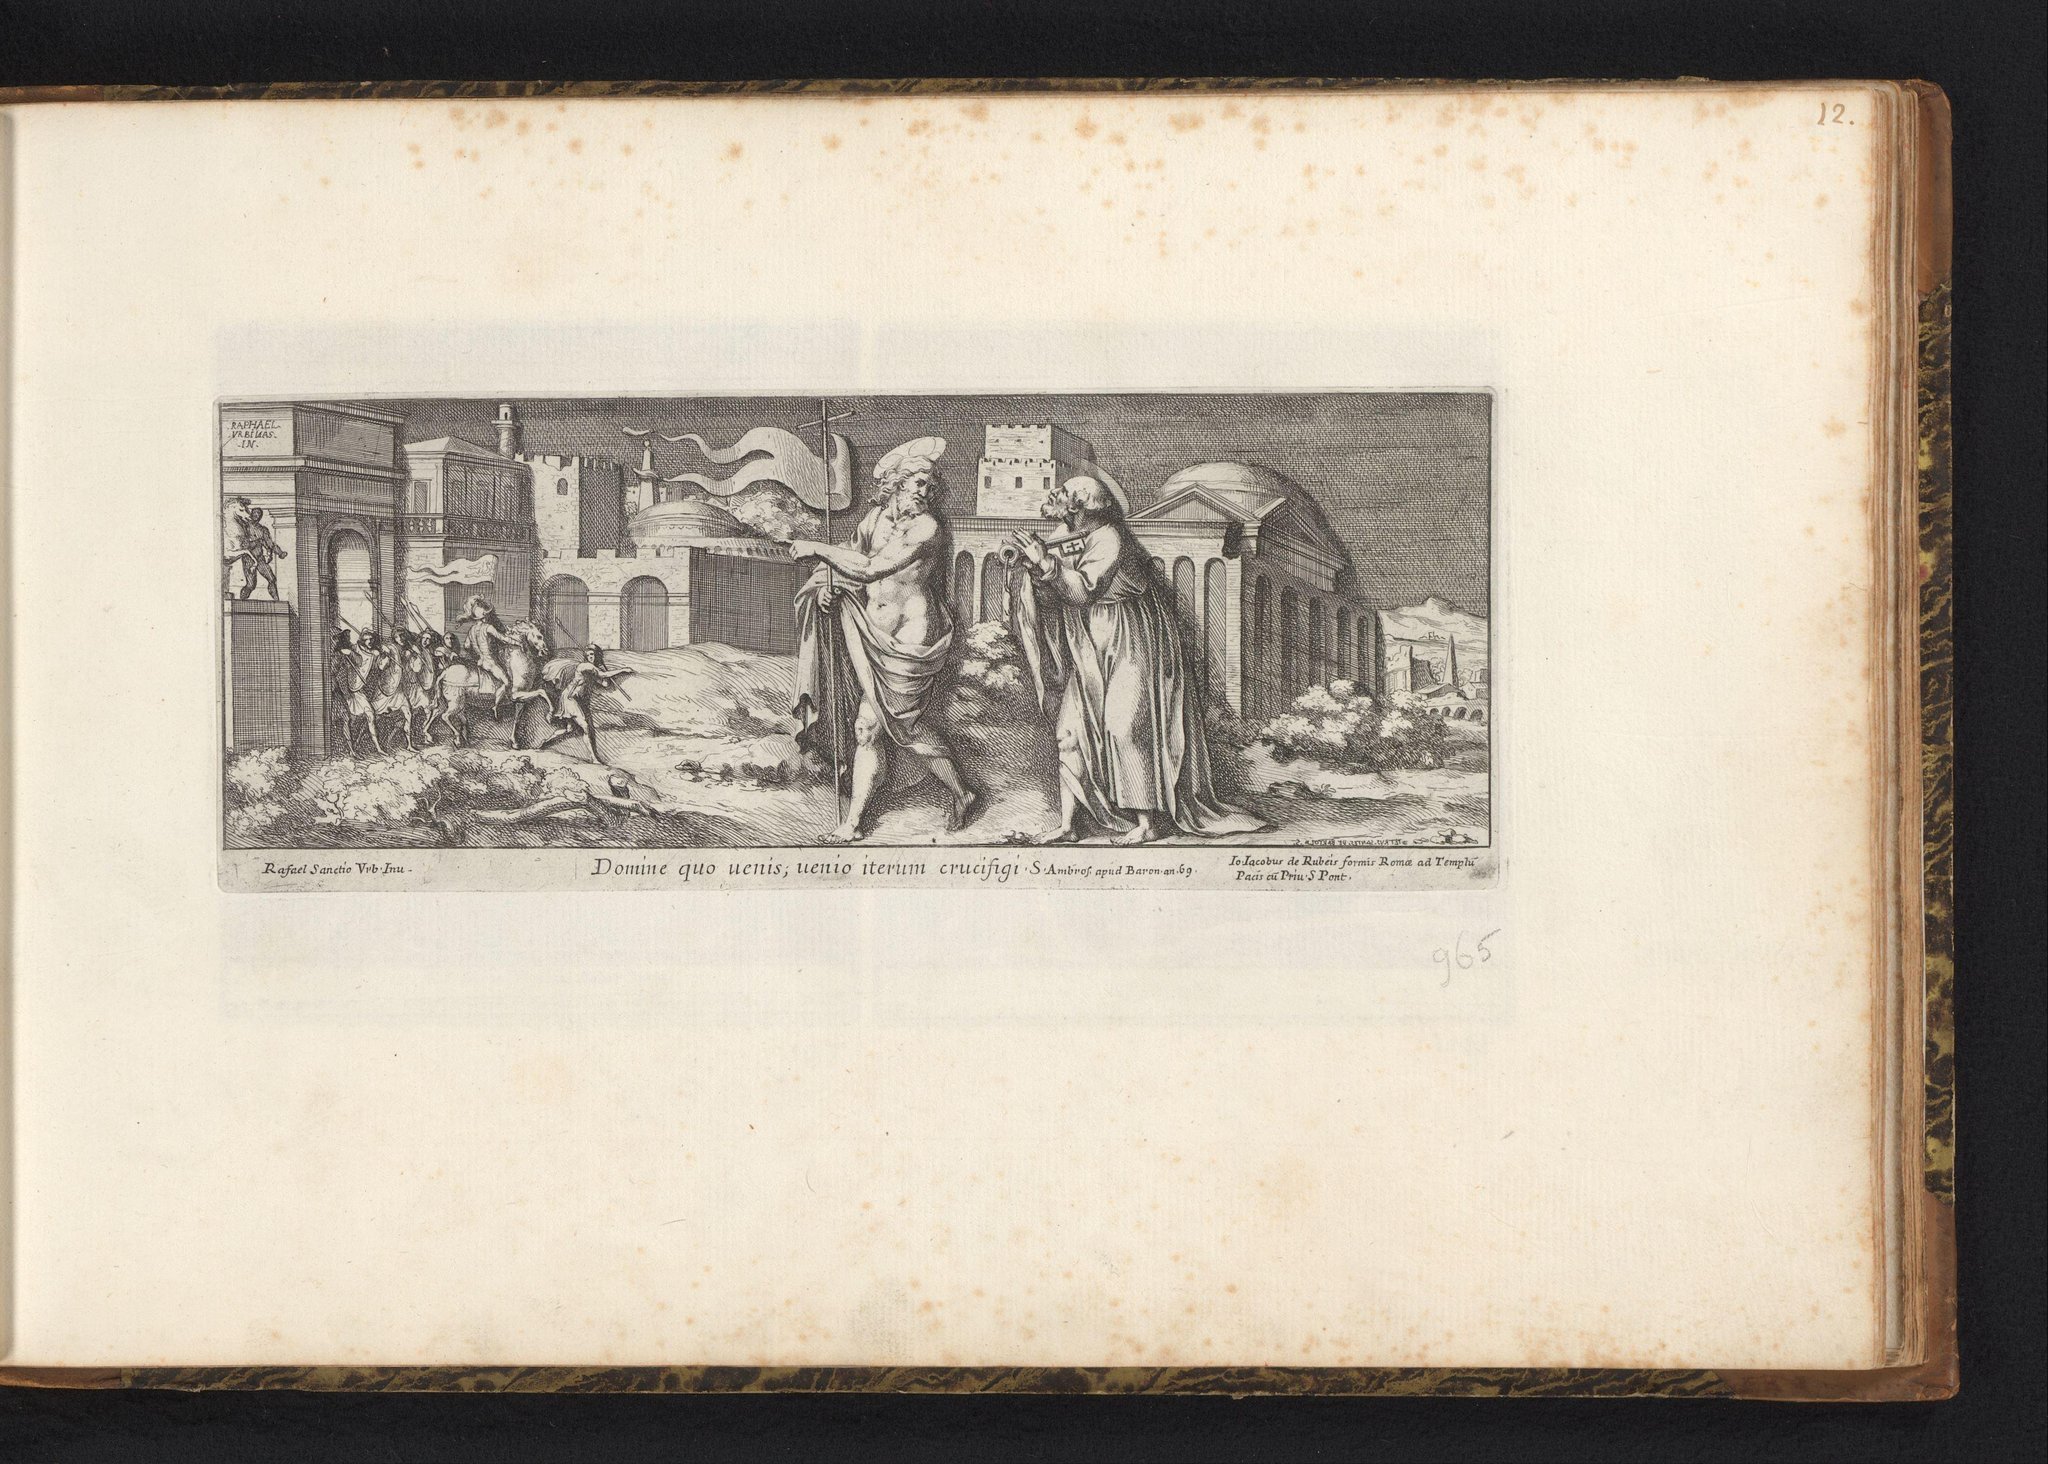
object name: album leaf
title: Domine quo uenis; uenio iterum crucifigi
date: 1645-1700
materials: paper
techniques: engraving, etching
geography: rome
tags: christ and paul on a boat: 'quo vadis'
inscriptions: number: ‘12’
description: Prent uit een reeks van 14 prenten (+ titelprent) naar schilderingen door Rafaël in de Stanze di Raffaello in het Apostolisch Paleis in het Vaticaan en naar ontwerpen voor wandtapijten voor de Sixtijnse Kapel door Rafaël. Naar een schildering door Rafaël in de Stanza dell'incendio del Borgo.